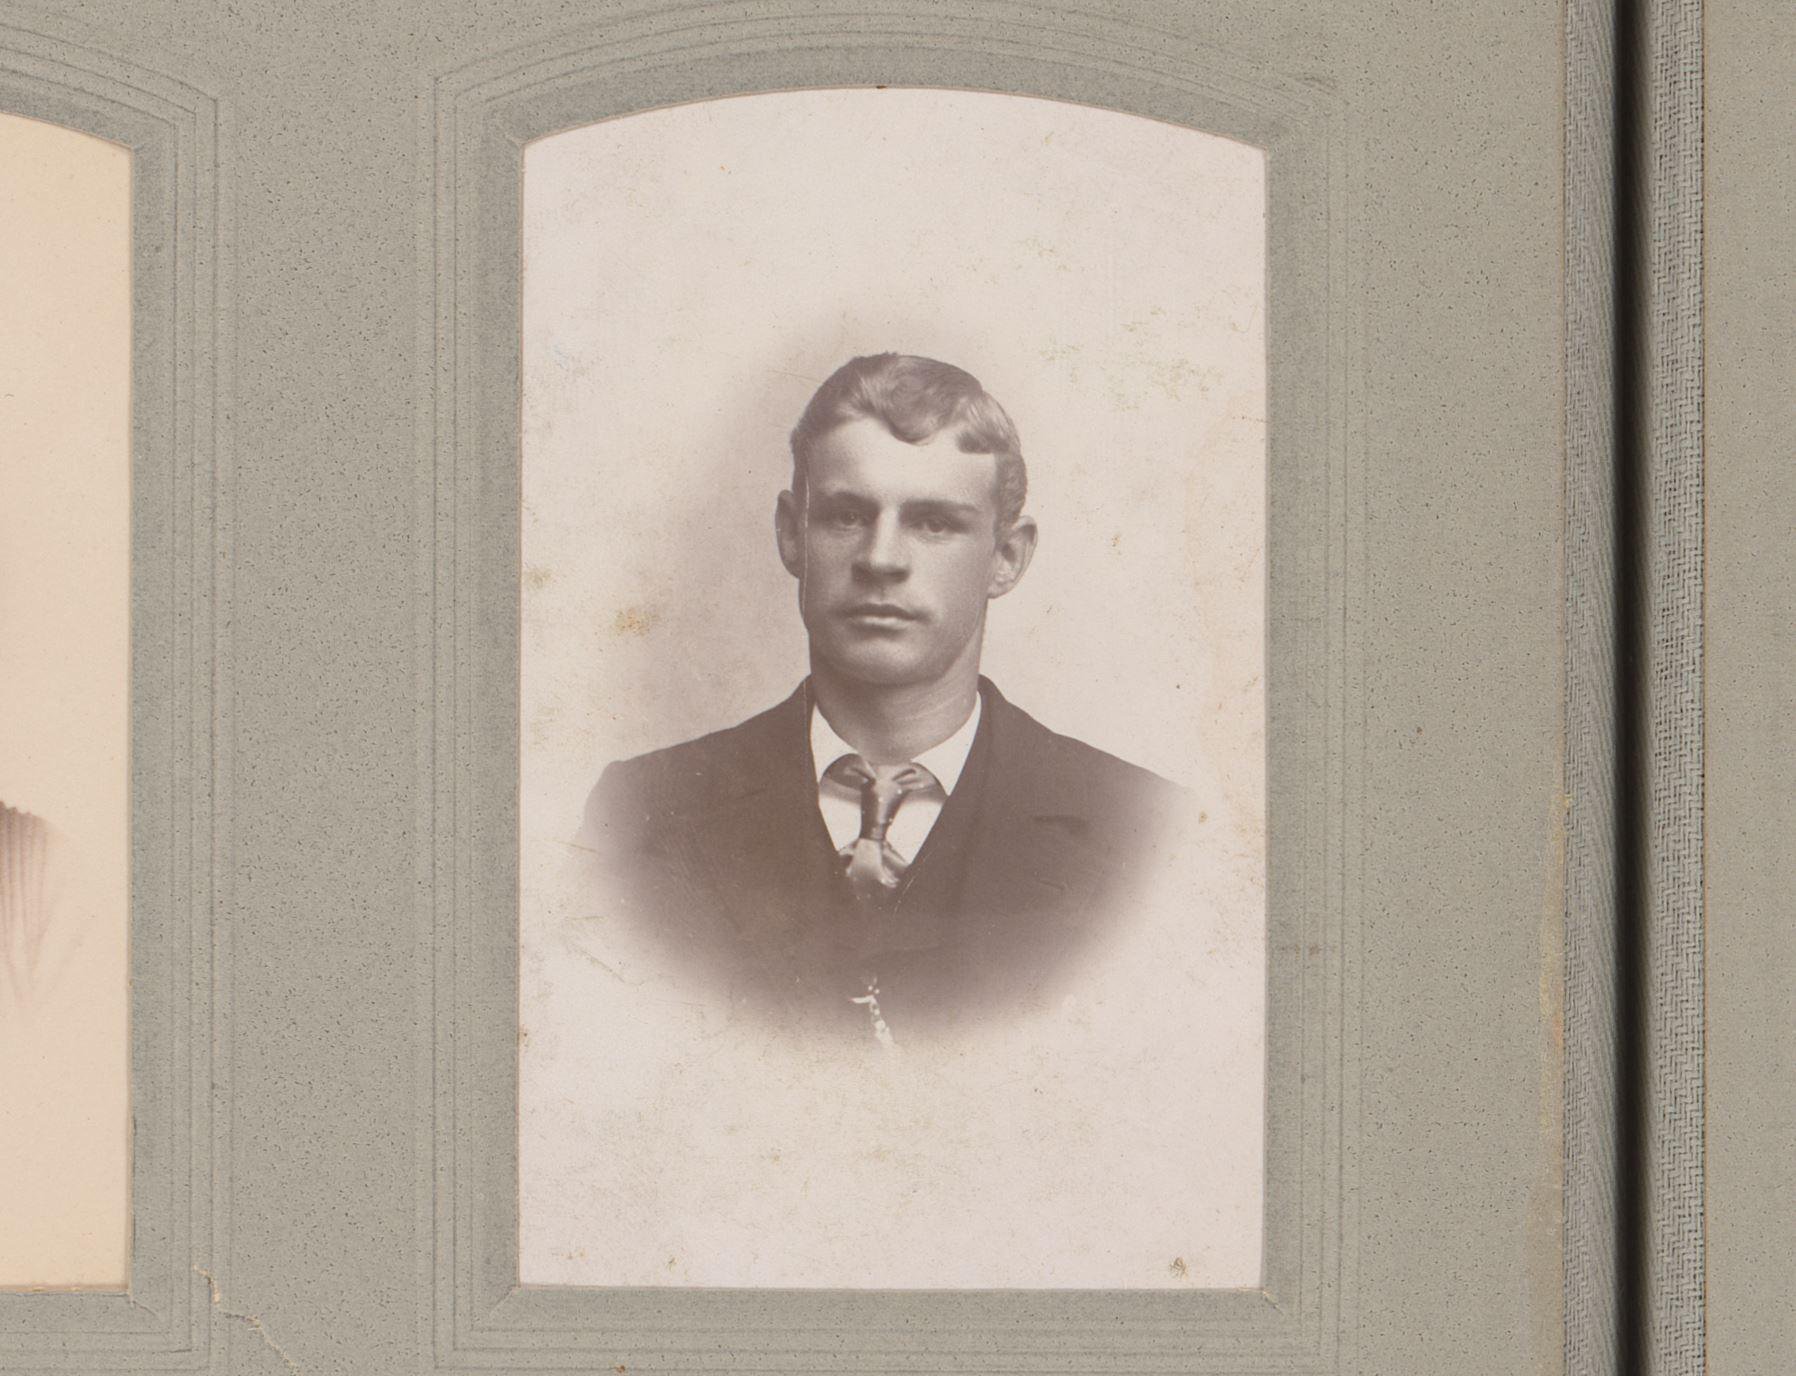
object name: photograph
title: Portret van een man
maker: oscar ellquist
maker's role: fotograaf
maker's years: 1867-1937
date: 1897-1920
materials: cardboard, photographic support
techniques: collodion silver print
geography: stockholm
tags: historical persons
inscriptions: inscription: ‘Allm. Telef. 131./ priisbelönt på utställningen/ stockholm/ 1897./ Oscar Ellqvist/ Stockholm/ Hamnagatan 18 A/ (SVEA SALEN)/ Plåten förvaras.’